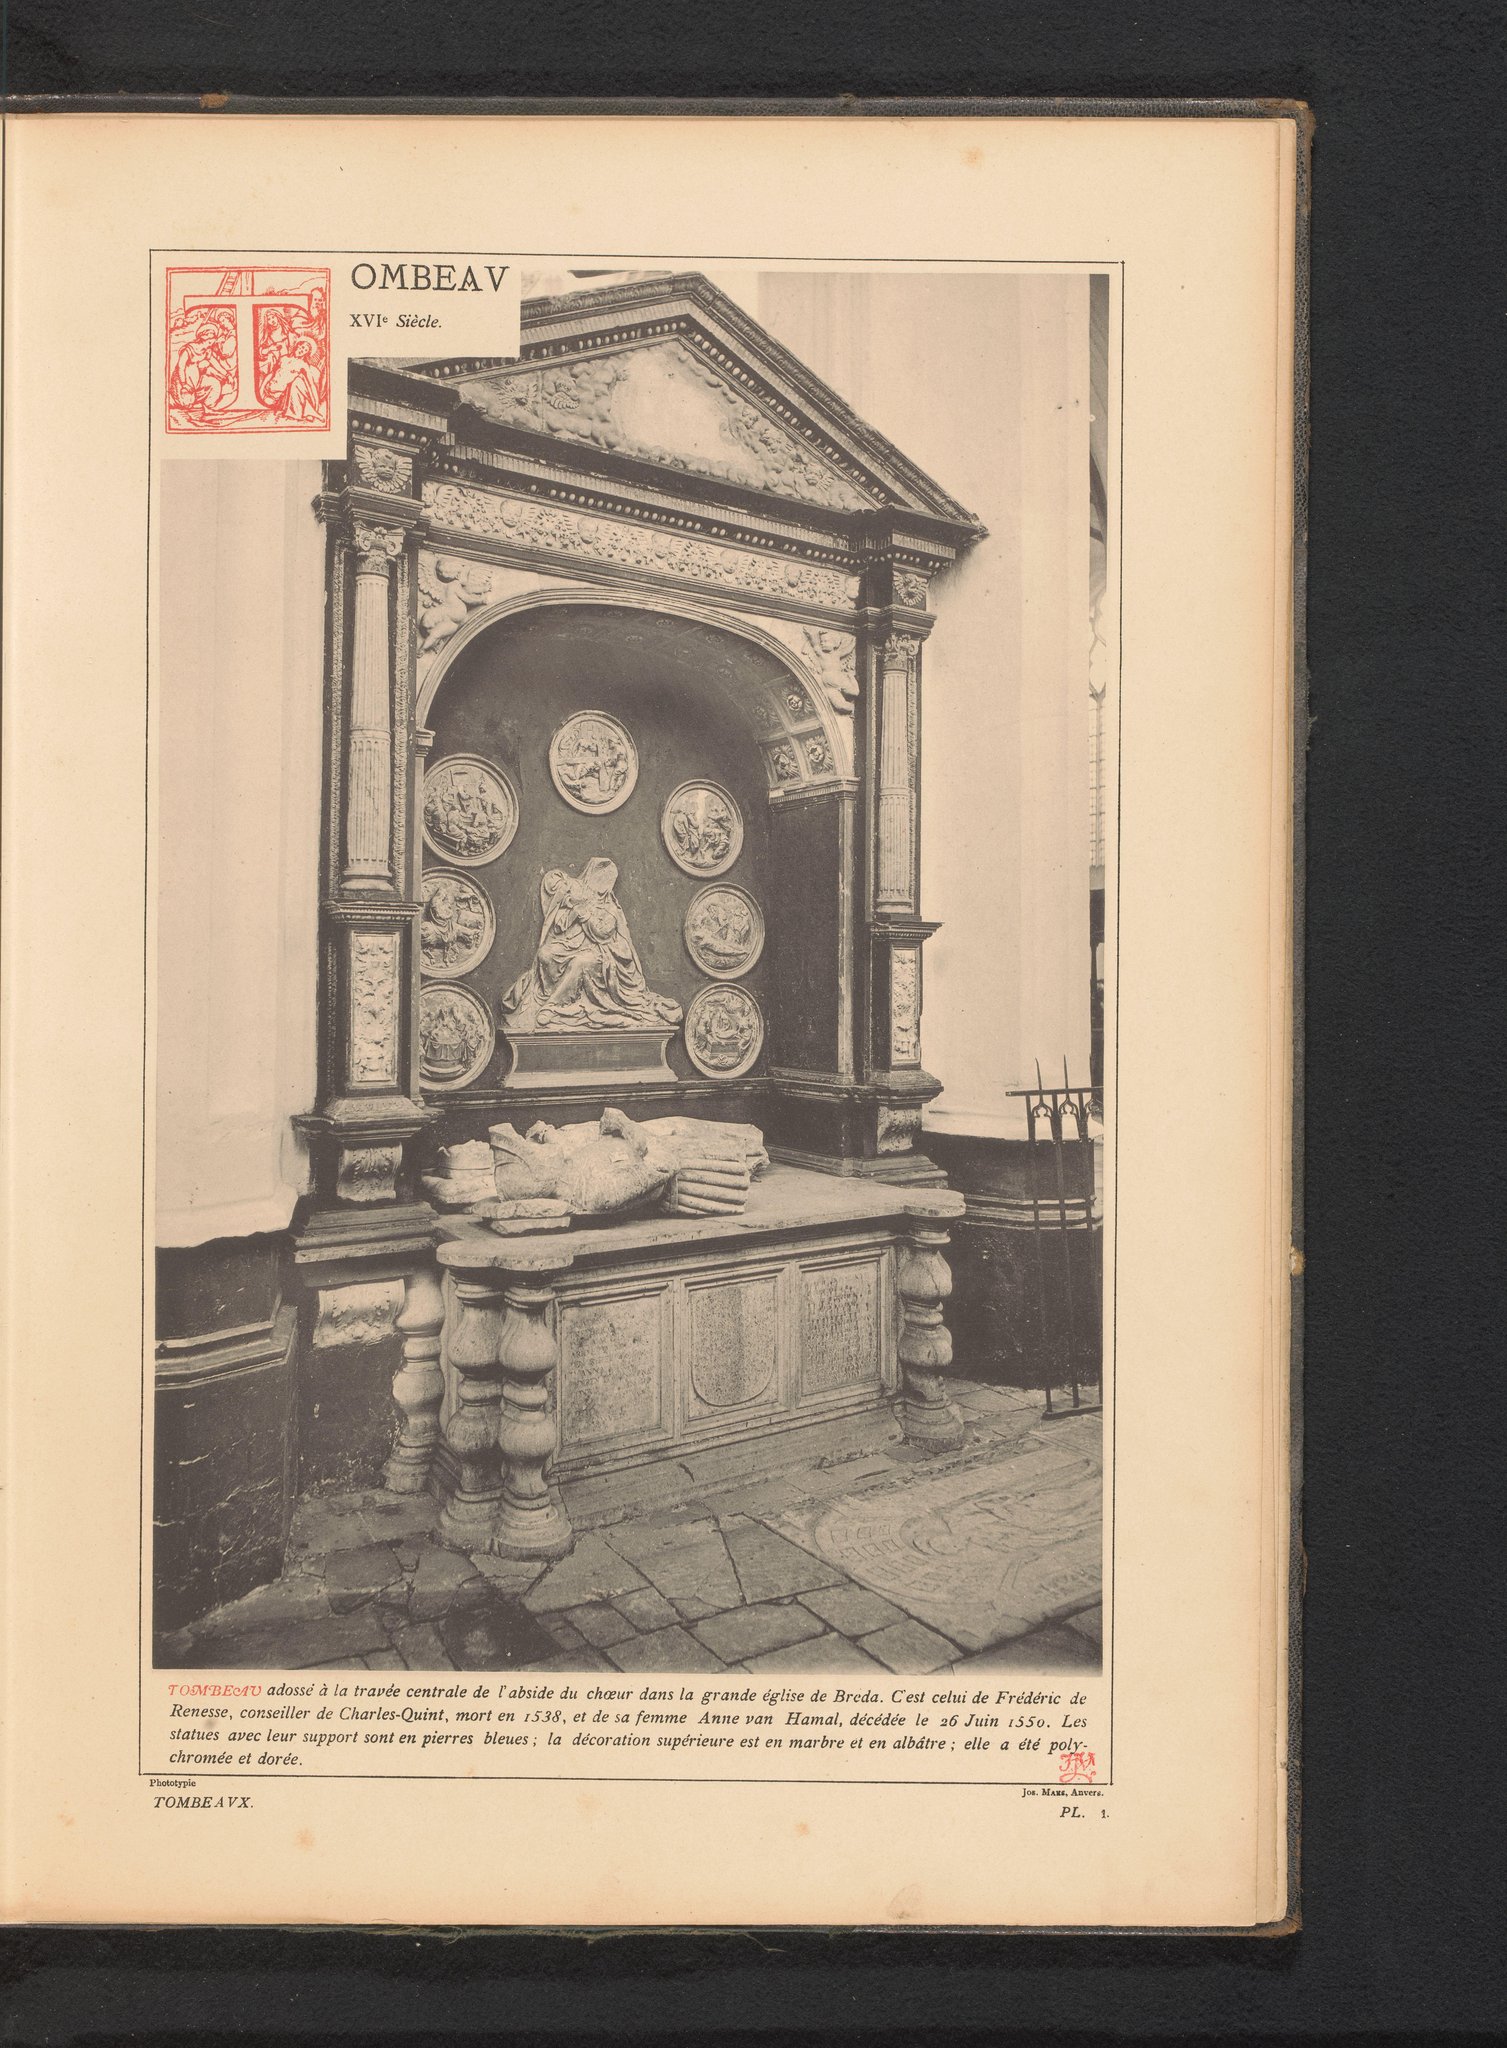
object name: page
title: Graftombe van Frederik van Renesse in de Grote Kerk te Breda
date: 1881-1889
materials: paper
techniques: photograph, photolithography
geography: breda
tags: utrecht, grave, tomb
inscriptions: inscription: ‘TOMBEAU adossé à (...)’, monogram: ‘JJvY’, inscription: ‘TOMBEAUX. PL. 1.’